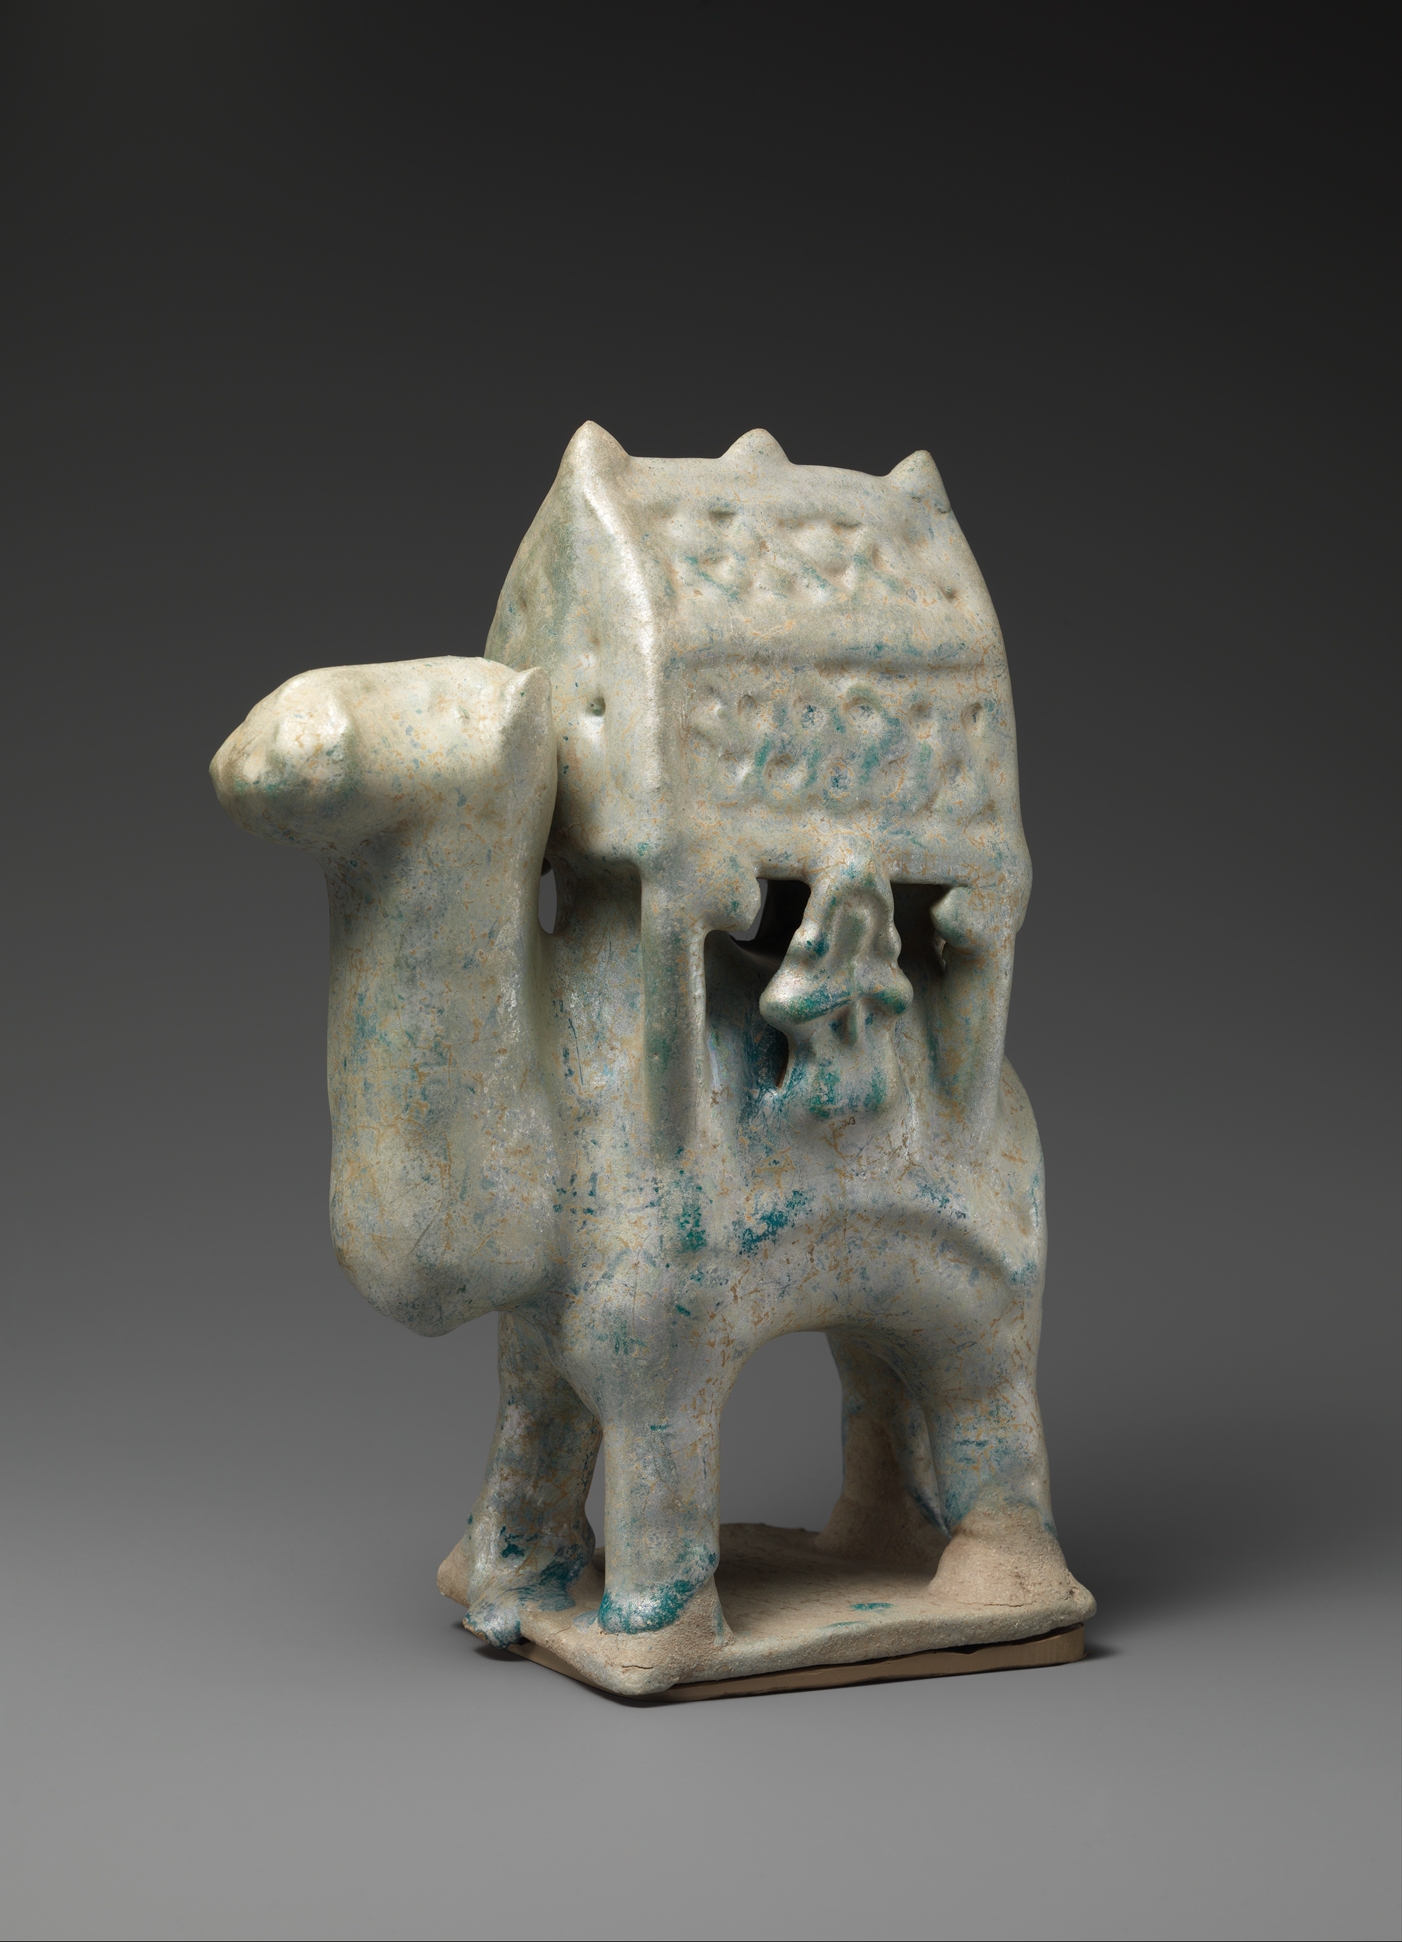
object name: figurine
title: Figurine in the Form of a Camel Carrying a Palanquin and Two Riders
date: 1101-1233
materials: stonepaste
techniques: glazing, molding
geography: iran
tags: camels